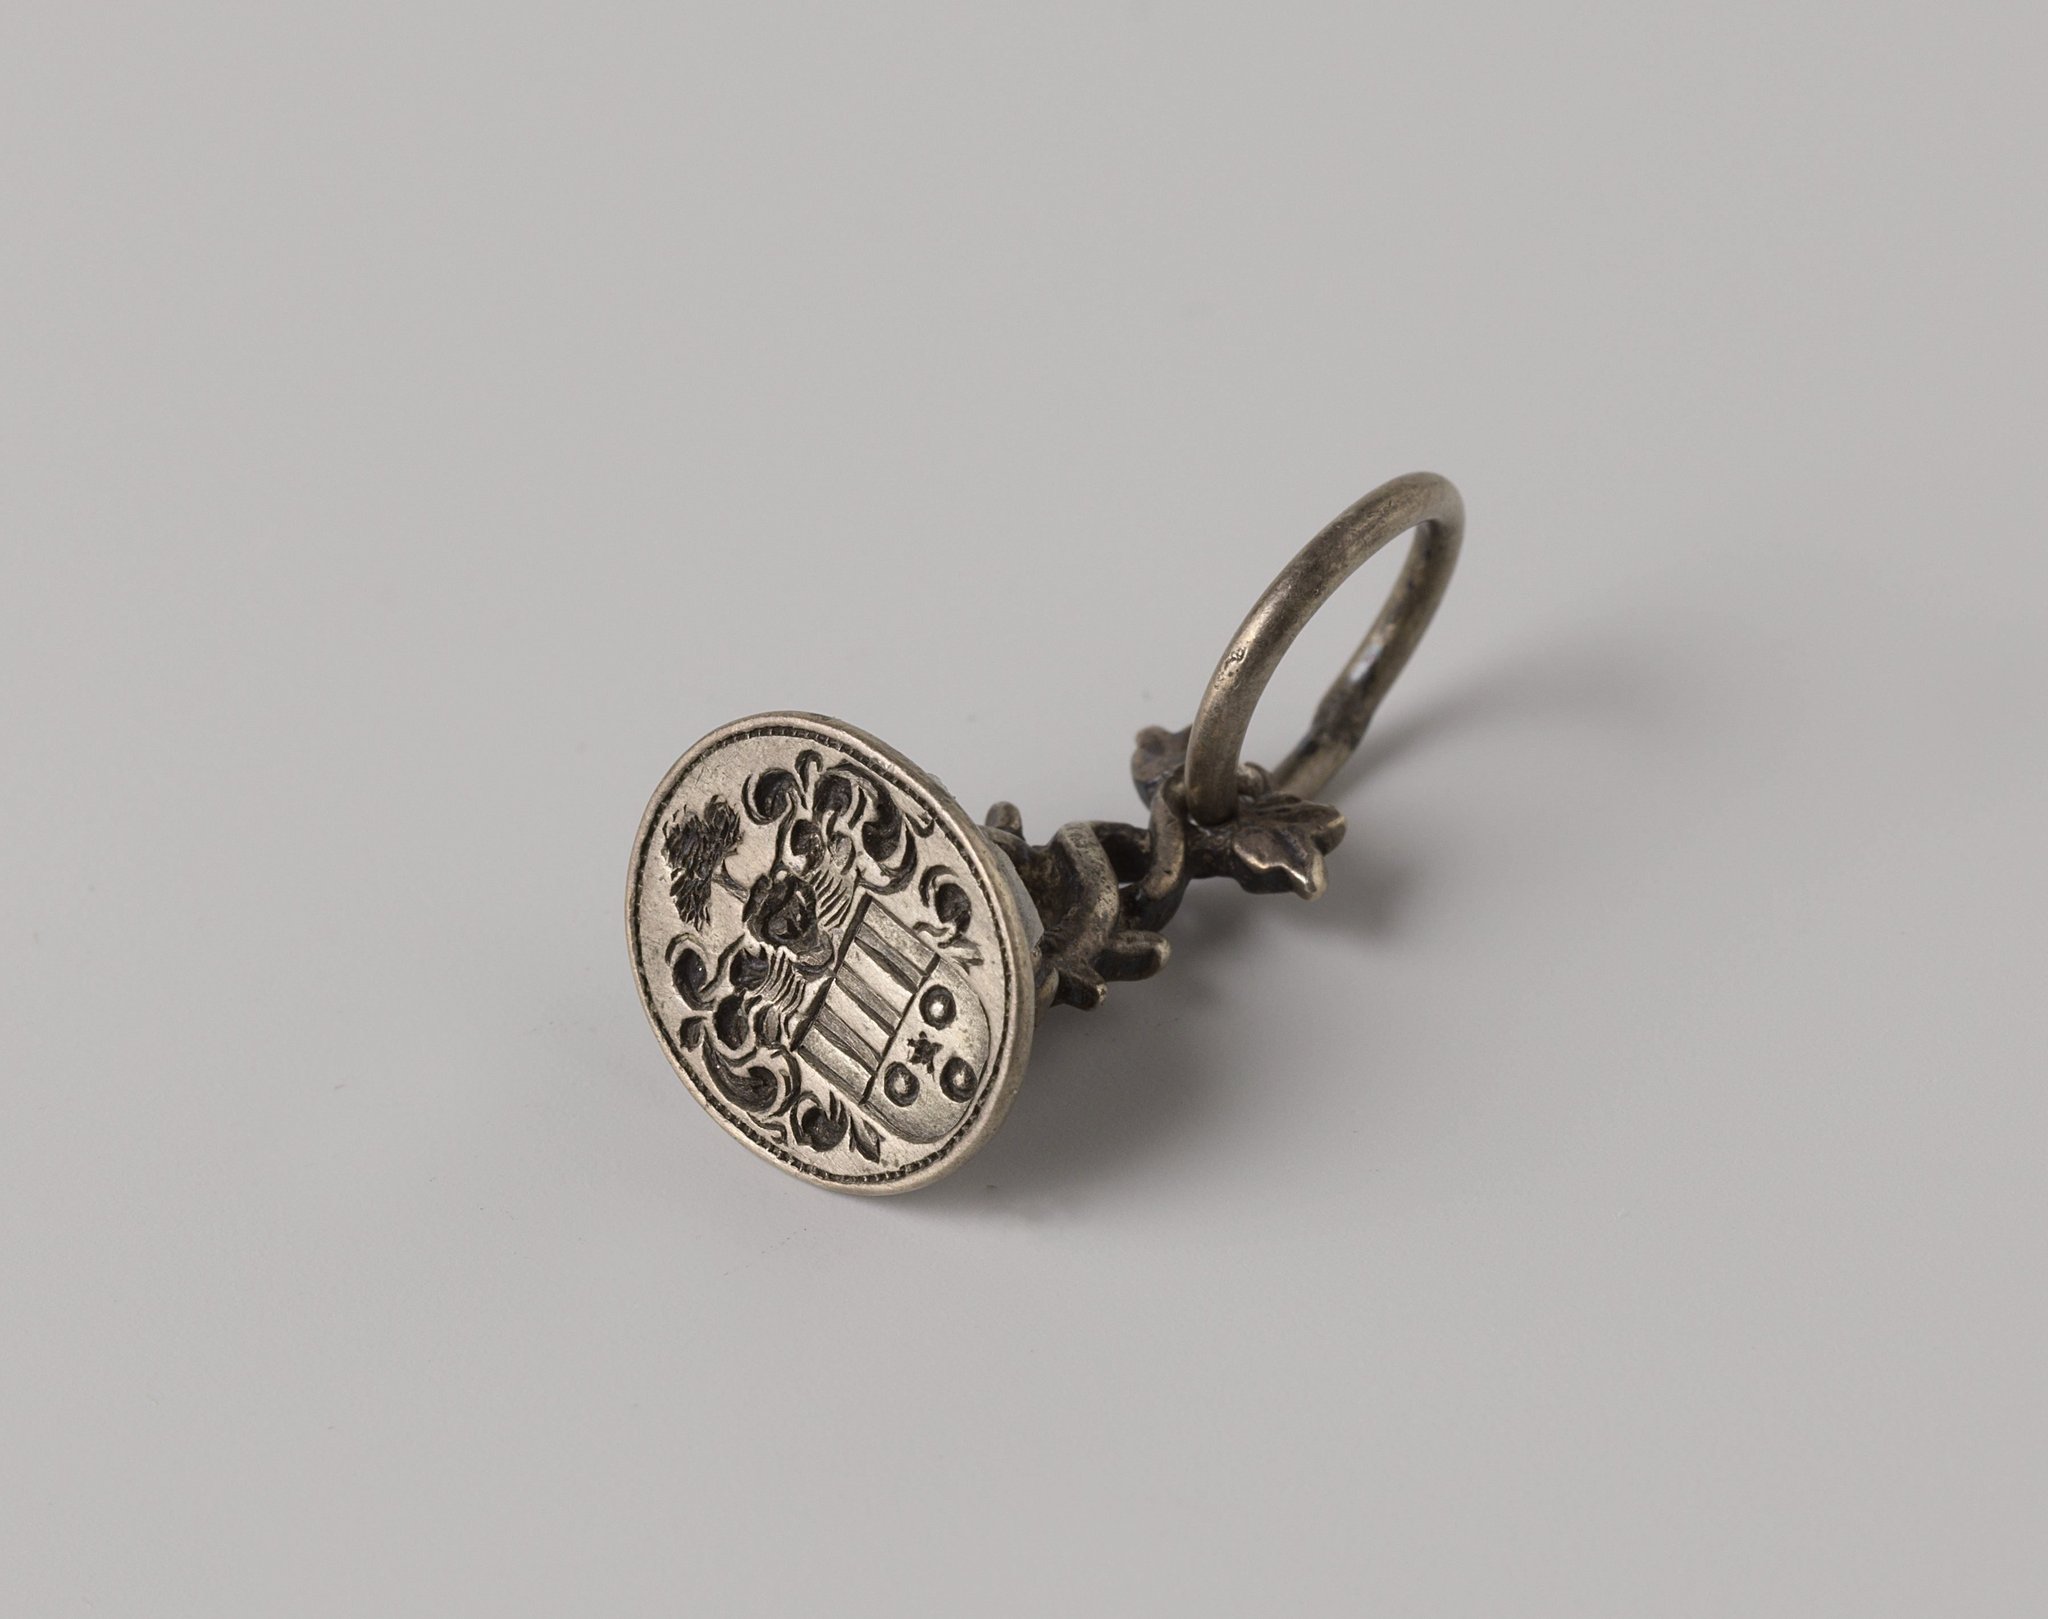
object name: zegelstempel, lakstempel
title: Cachet van Louis Boisot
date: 1500-1600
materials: silver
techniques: casting, forging, striking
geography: netherlands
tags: netherlands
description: Kleine ovale zegelstempel, het handvat bestaande uit twee verstrengelde monstervissen, aan hun staart een draagring. Gehelmd wapen, op de helm een boom. De bovenste helft van het schild bestaat uit zeven verticale banen, op de onderste helft drie ringen rond een vijfpuntige ster. Gemerkt: Op de voet.